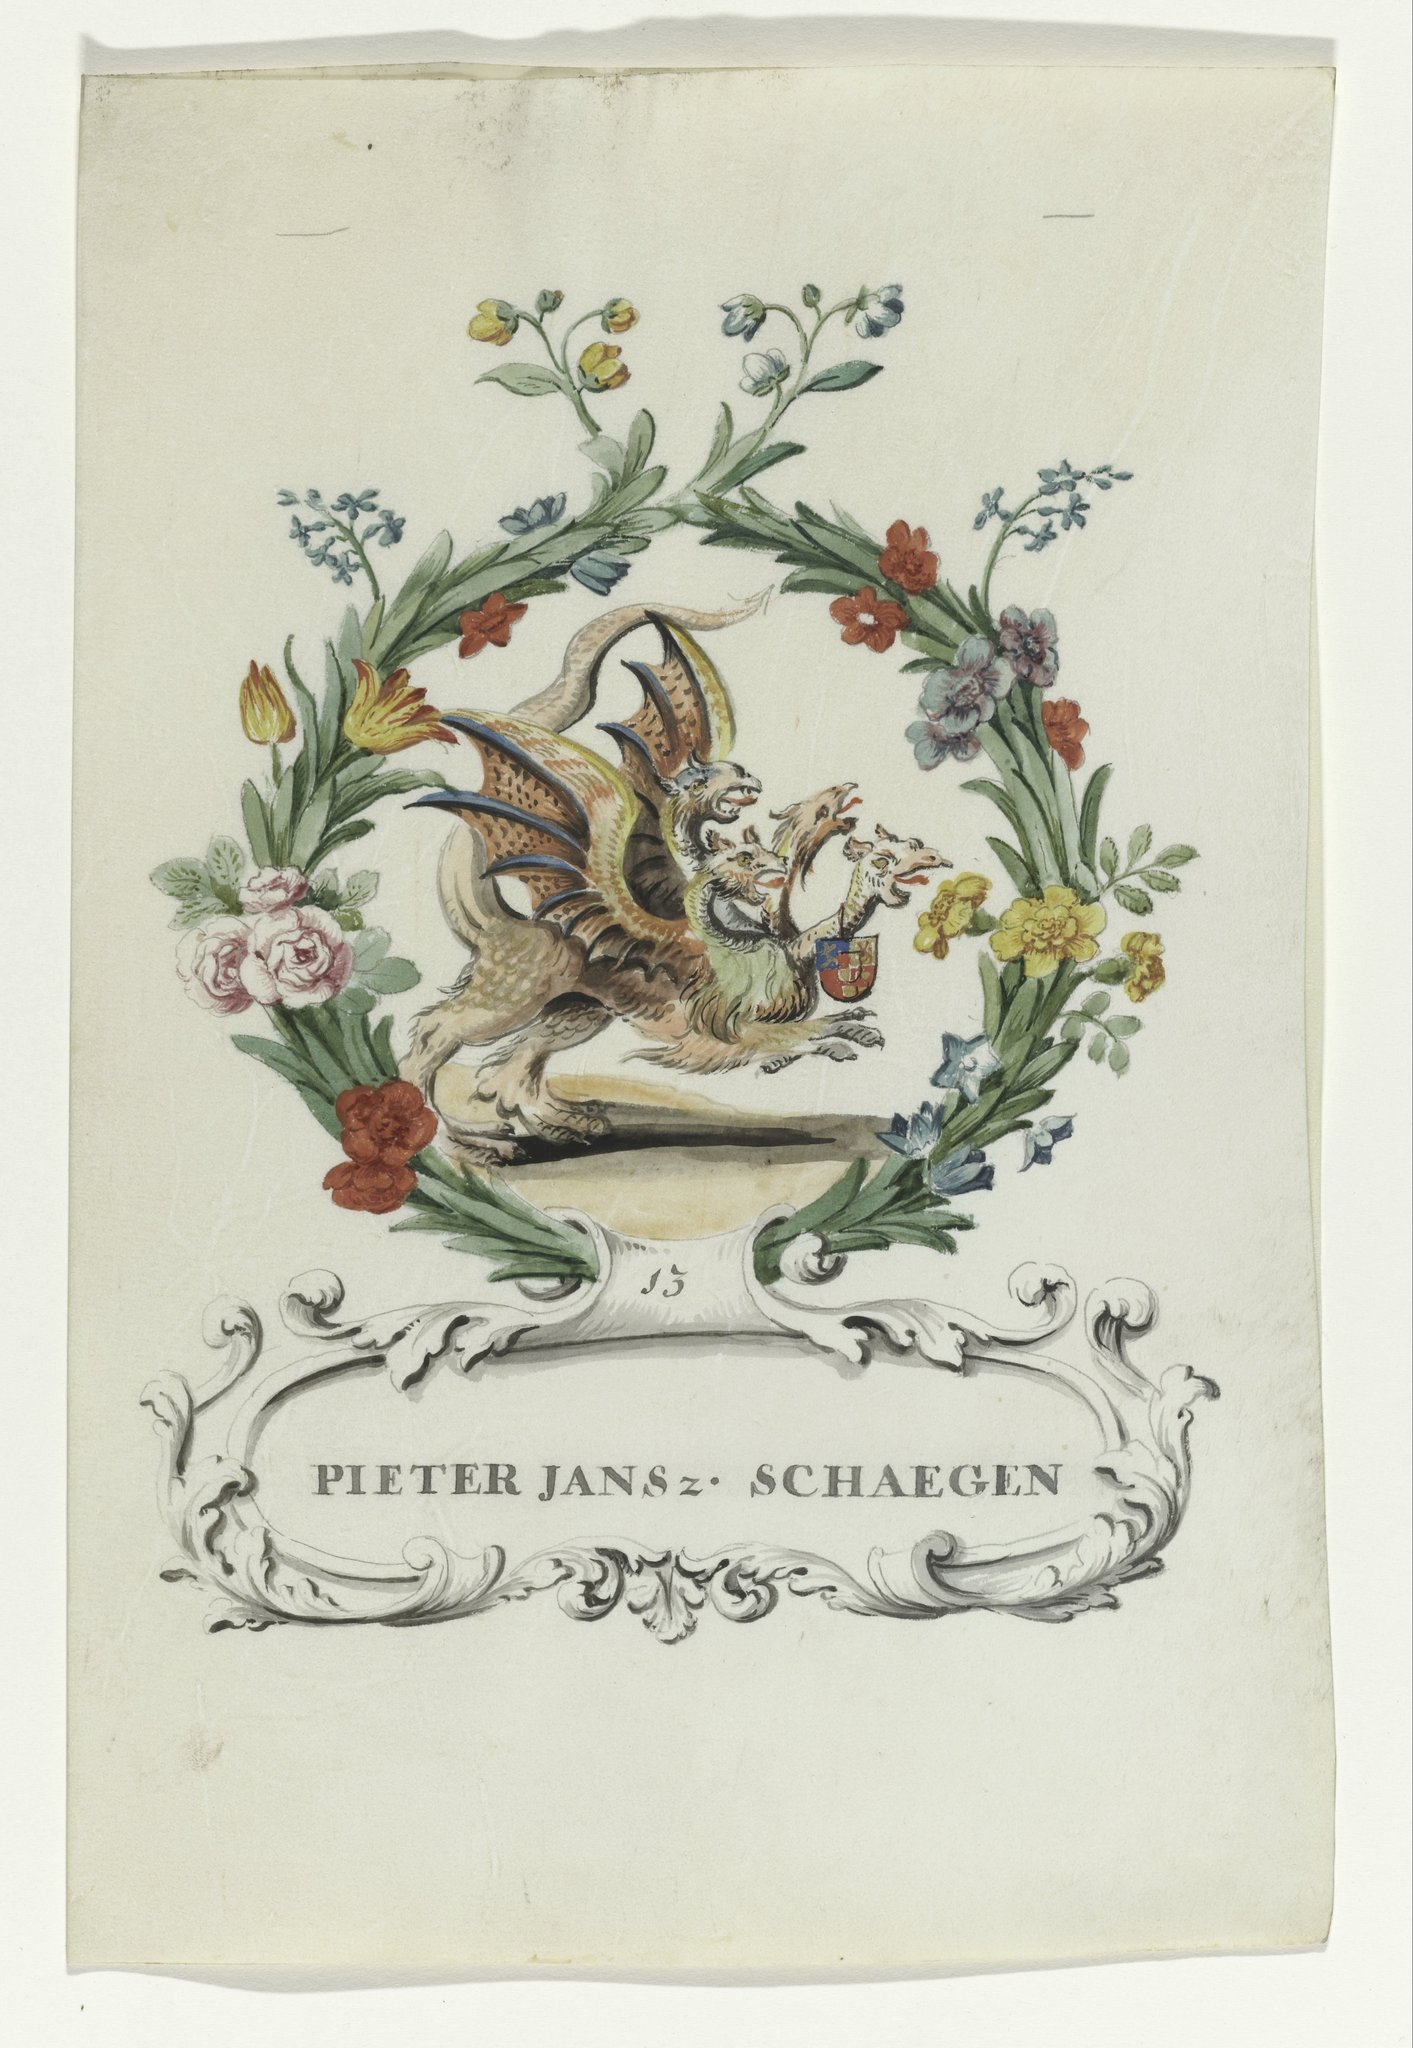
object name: cartoon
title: Spotprent van Pieter Jansz. Schaegen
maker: Anonymous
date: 1710-1720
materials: ink, parchment, watercolor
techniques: brush, pen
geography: netherlands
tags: the hague, johan van oldenbarnevelt, politician, dragon (large fabulous serpent, sometimes with wings and legs), caricatures (human types), bad, corrupt judge, political caricatures and satires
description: Spotprent van Pieter Jansz. Schaegen, rechter van Van Oldenbarnevelt; vierkoppige draak met aan één hals een wapen, in krans van bloemen en bladeren. Daaronder cartouche waarin naam en daarboven nr. 13. Behorende bij serie aquarellen in boek.